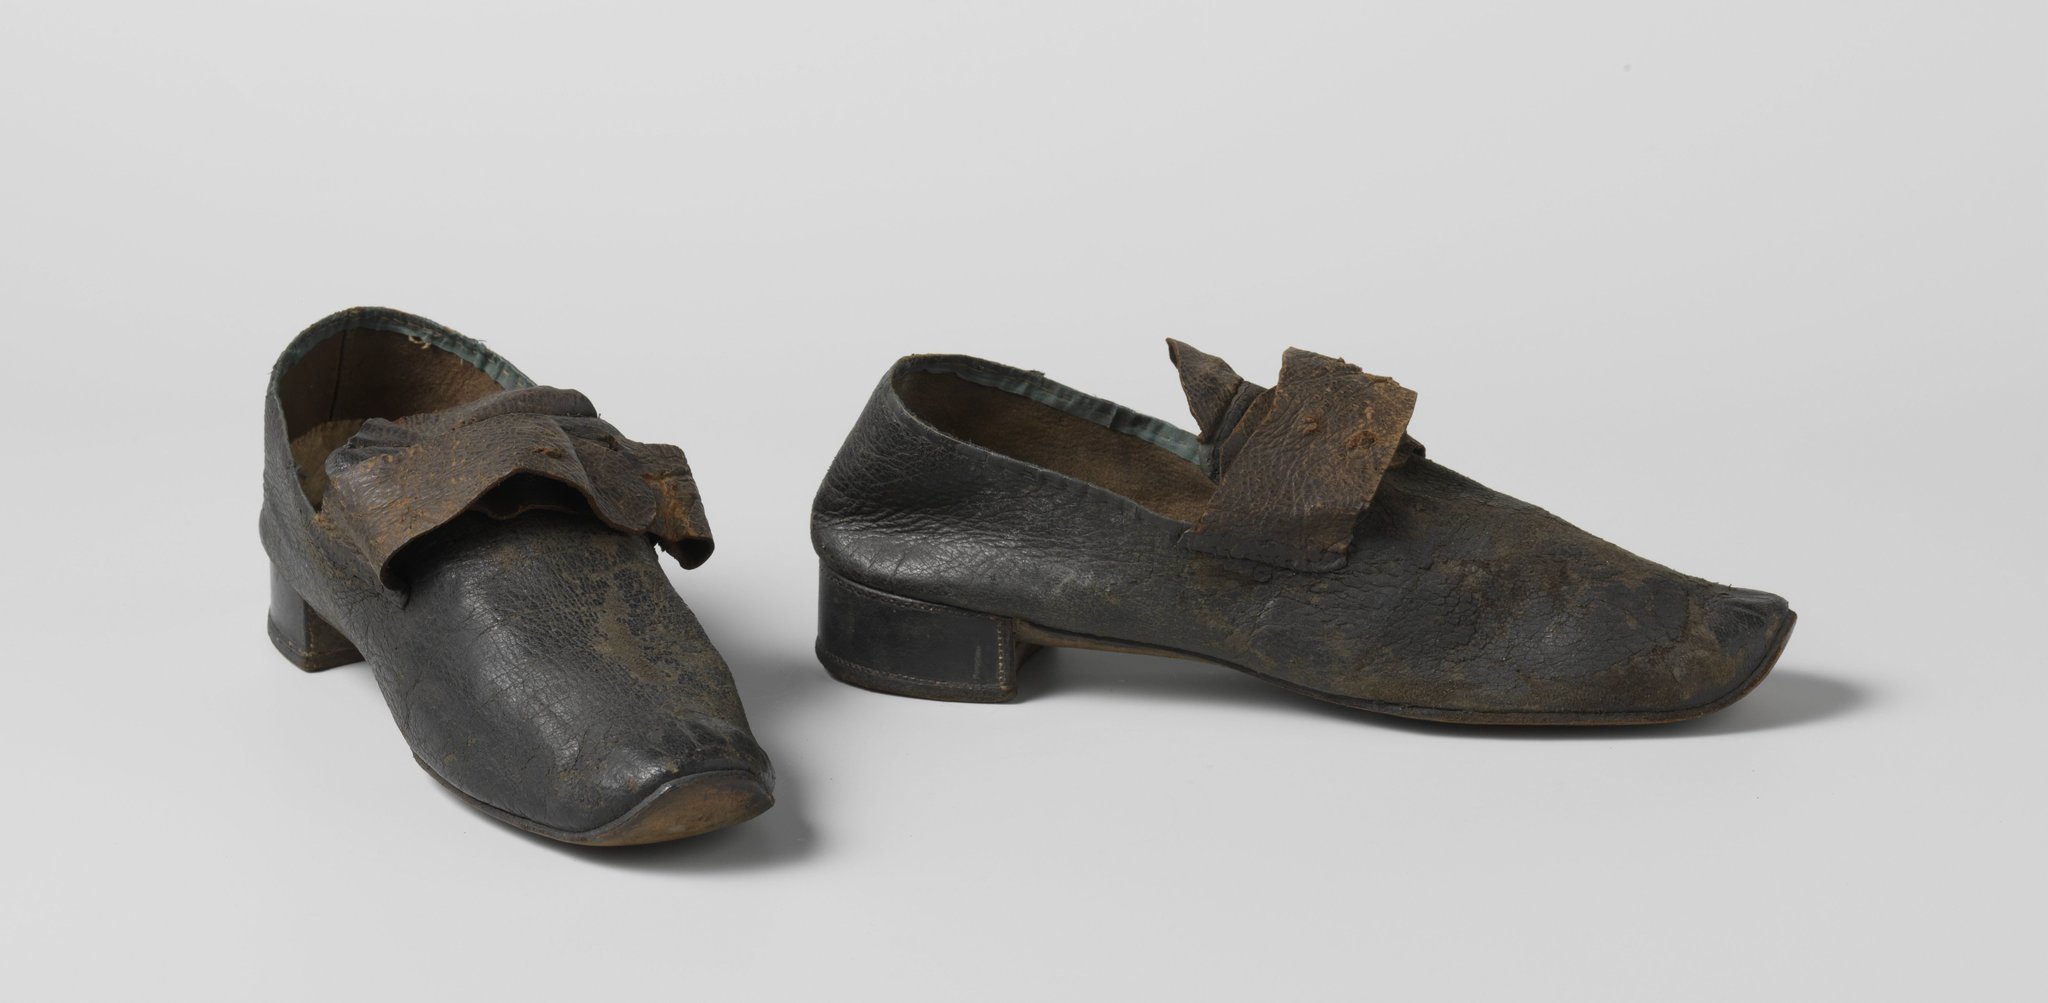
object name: menswear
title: Schoen van zwart leer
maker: Anonymous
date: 1670-1700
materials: leather, silk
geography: northern netherlands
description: Schoen van zwart leer. Model: platte ronde neus die iets oploopt. Opgebouwd uit een blad, met apart aangezette sluitriemen, die bij de hiel aan elkaar genaaid is. Een hoog voorblad, met een verlengstuk. De hak is geheel van leer. De gehele schoen is gemaakt van leer en met blauw lint afgebiesd.